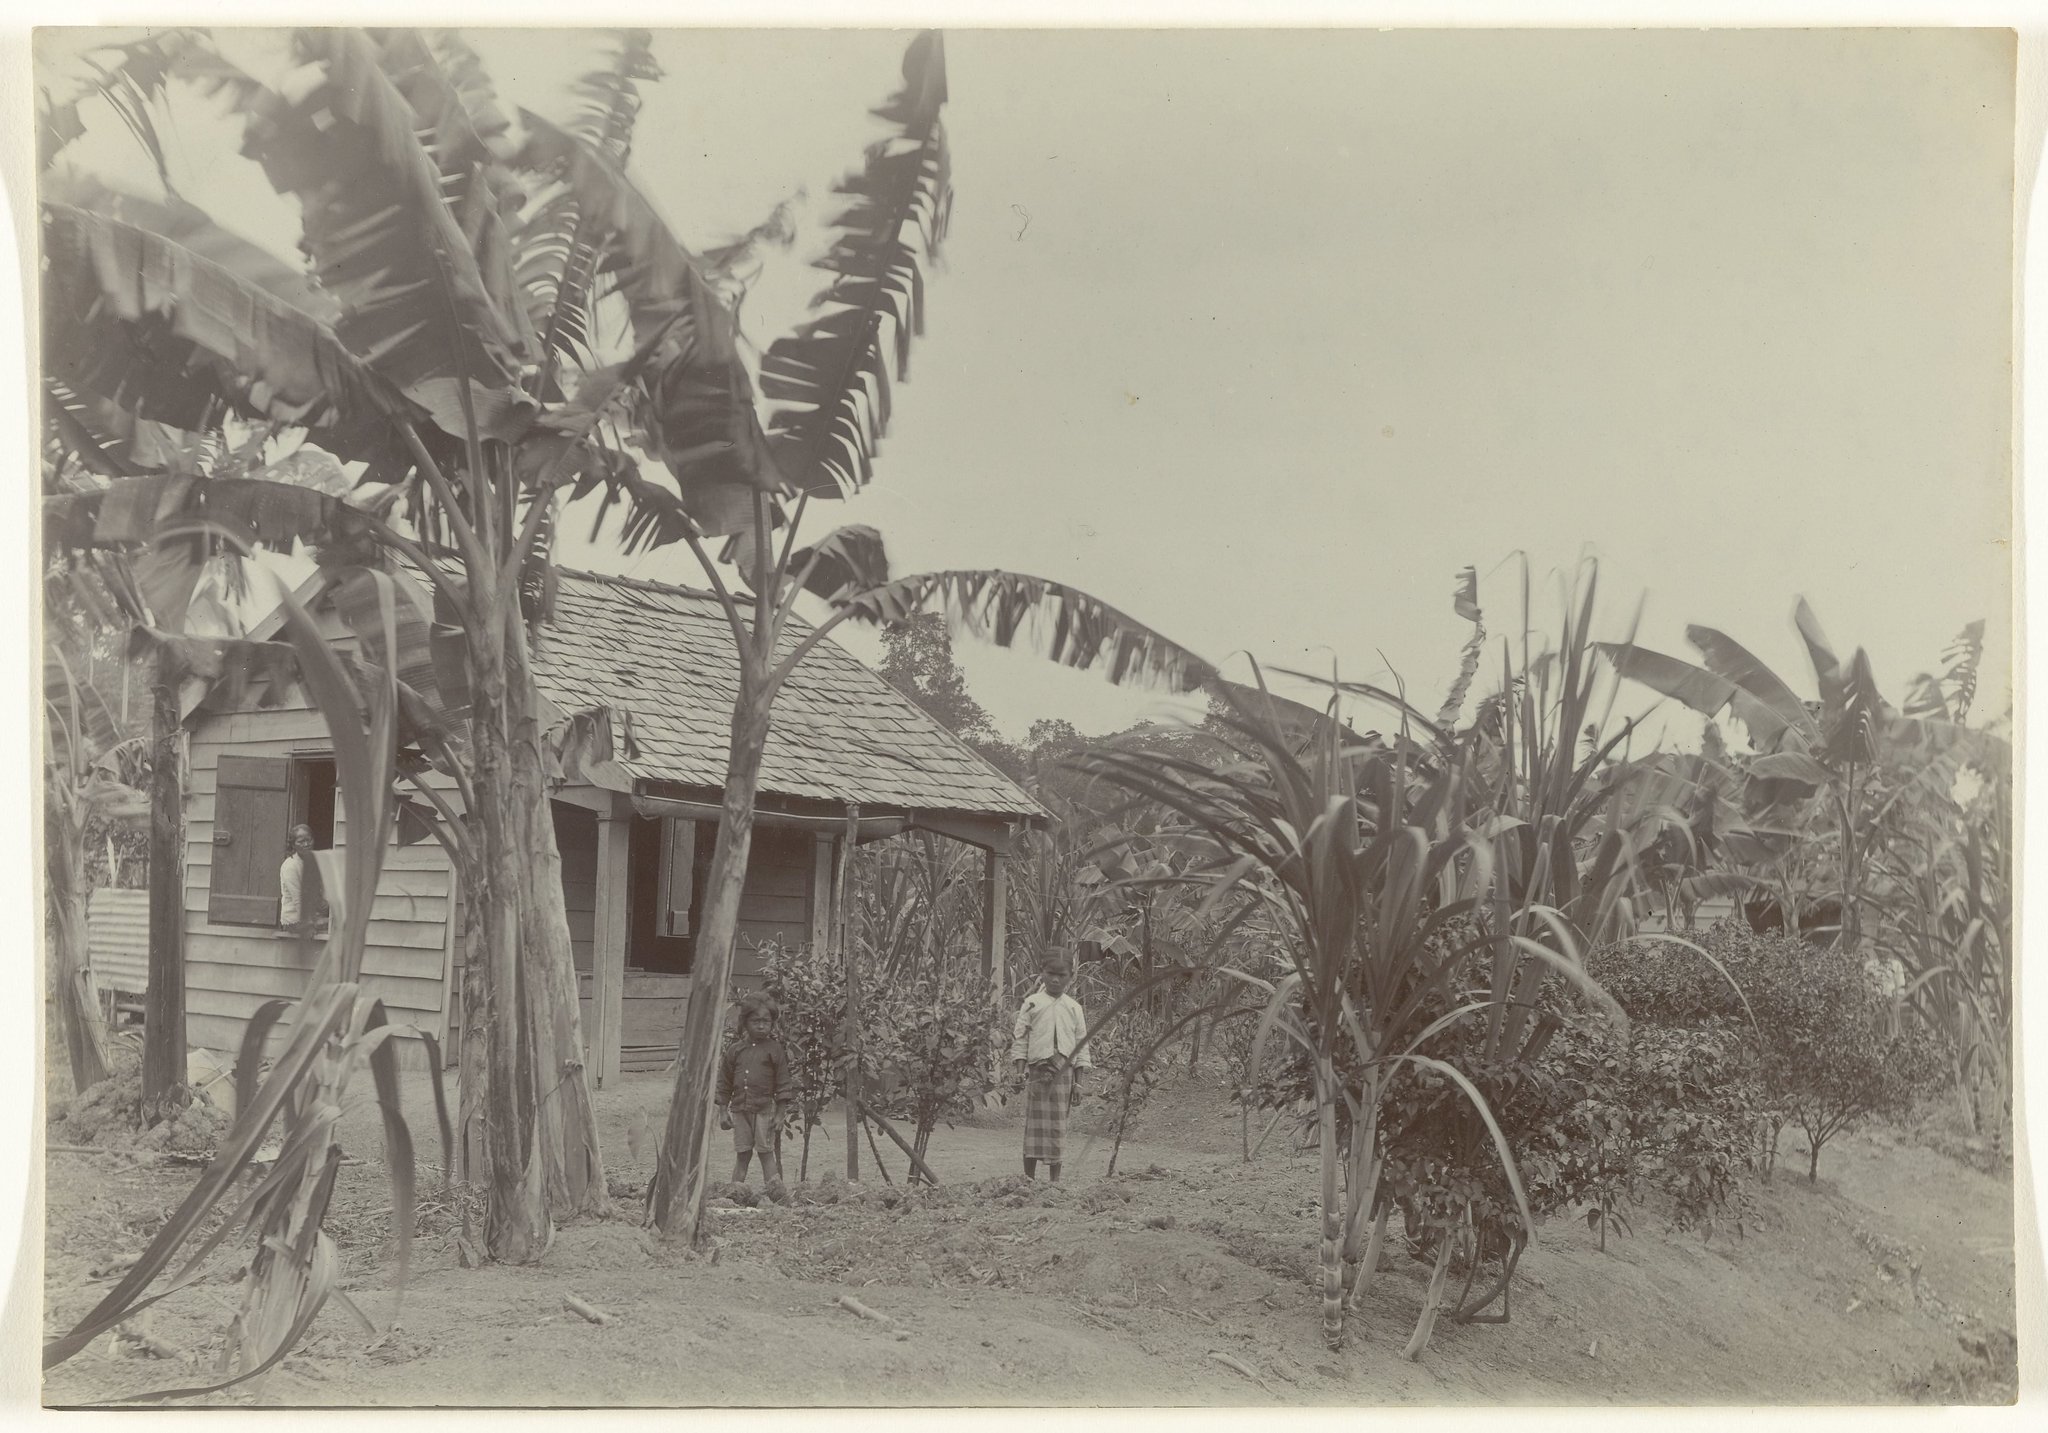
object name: photograph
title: Arbeiderswoning met arbeiders op plantage Johanna-Catherina te Suriname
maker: theodoor brouwers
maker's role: amateurfotograaf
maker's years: 1874-1932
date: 1918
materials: photographic support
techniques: gelatin silver print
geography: suriname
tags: theodoor brouwers, plantation, suriname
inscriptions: inscription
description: Klein houten huis temidden van bananenbomen op Plantage Johanna-Catharina, met twee poserende mensen.